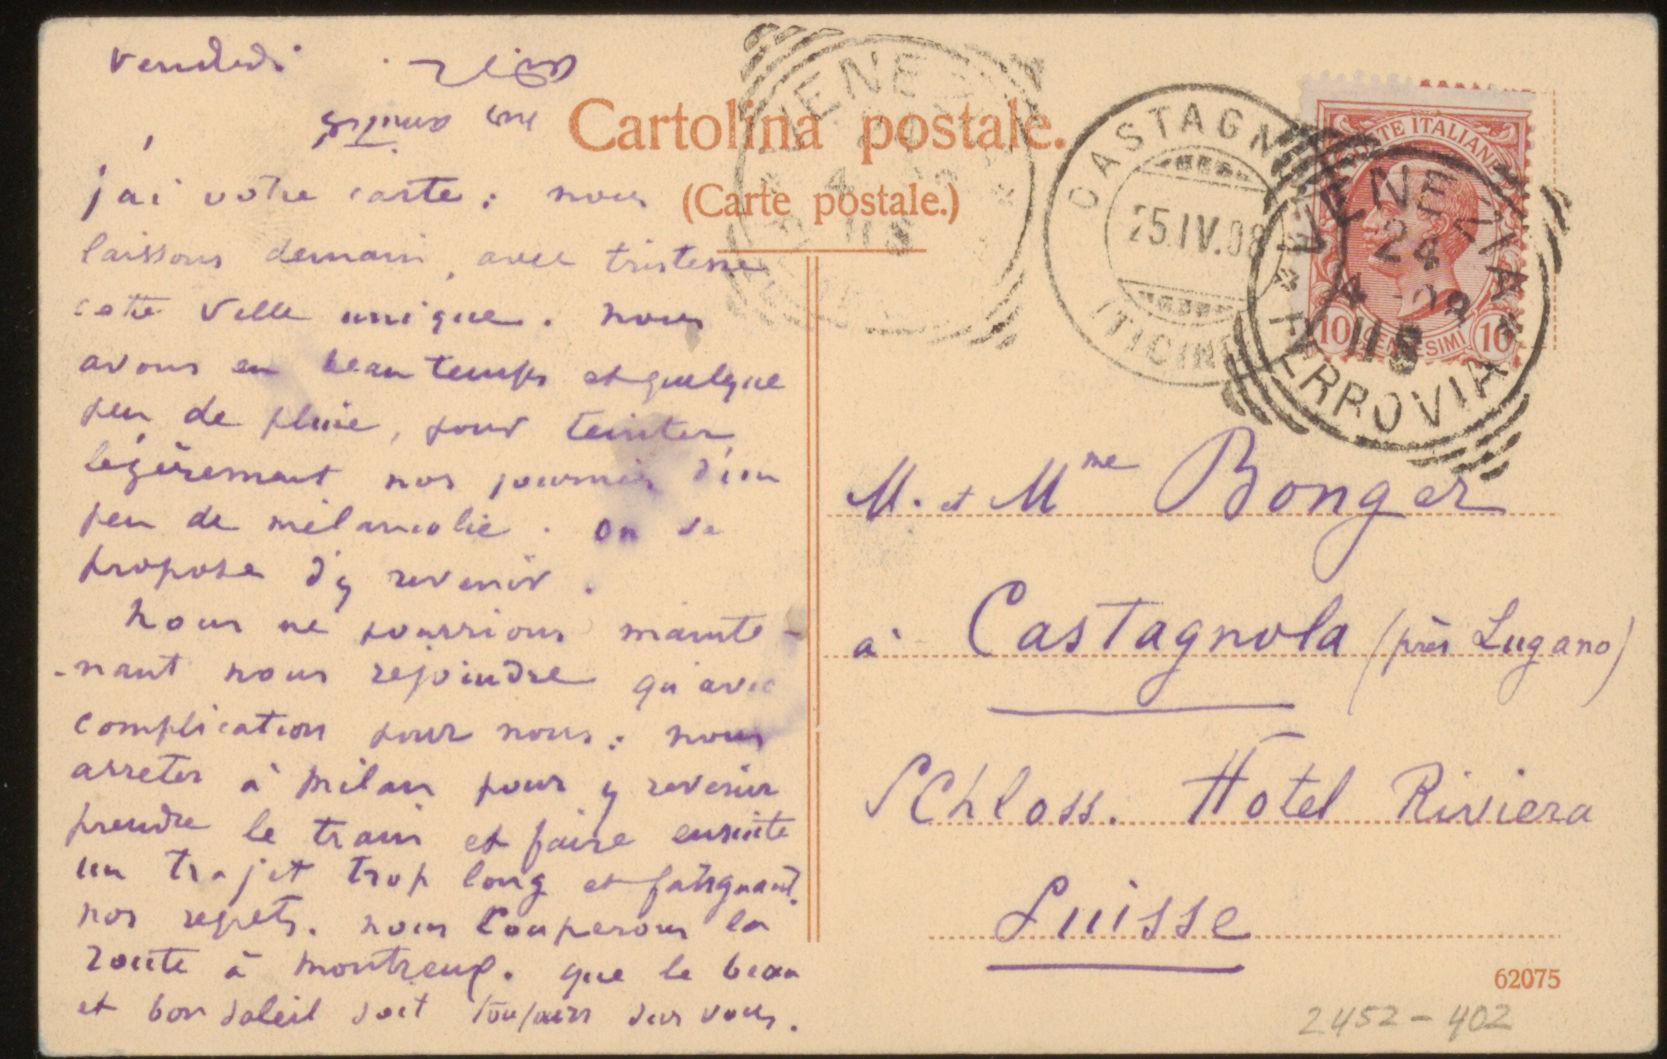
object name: ansichtkaart, prentbriefkaart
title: Prentbriefkaart aan Andries Bonger en Anne Marie Louise van der Linden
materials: cardboard, ink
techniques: photograph, pen, writing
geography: venice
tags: andries bonger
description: Prentbriefkaart behoort tot een album samengesteld door weduwe Françoise W.M. Barones van der Borch van Verwolde met afschriften van brieven met betrekking tot (de familie van) Odilon Redon. De prentbriefkaart werd bewaard op pagina 144.